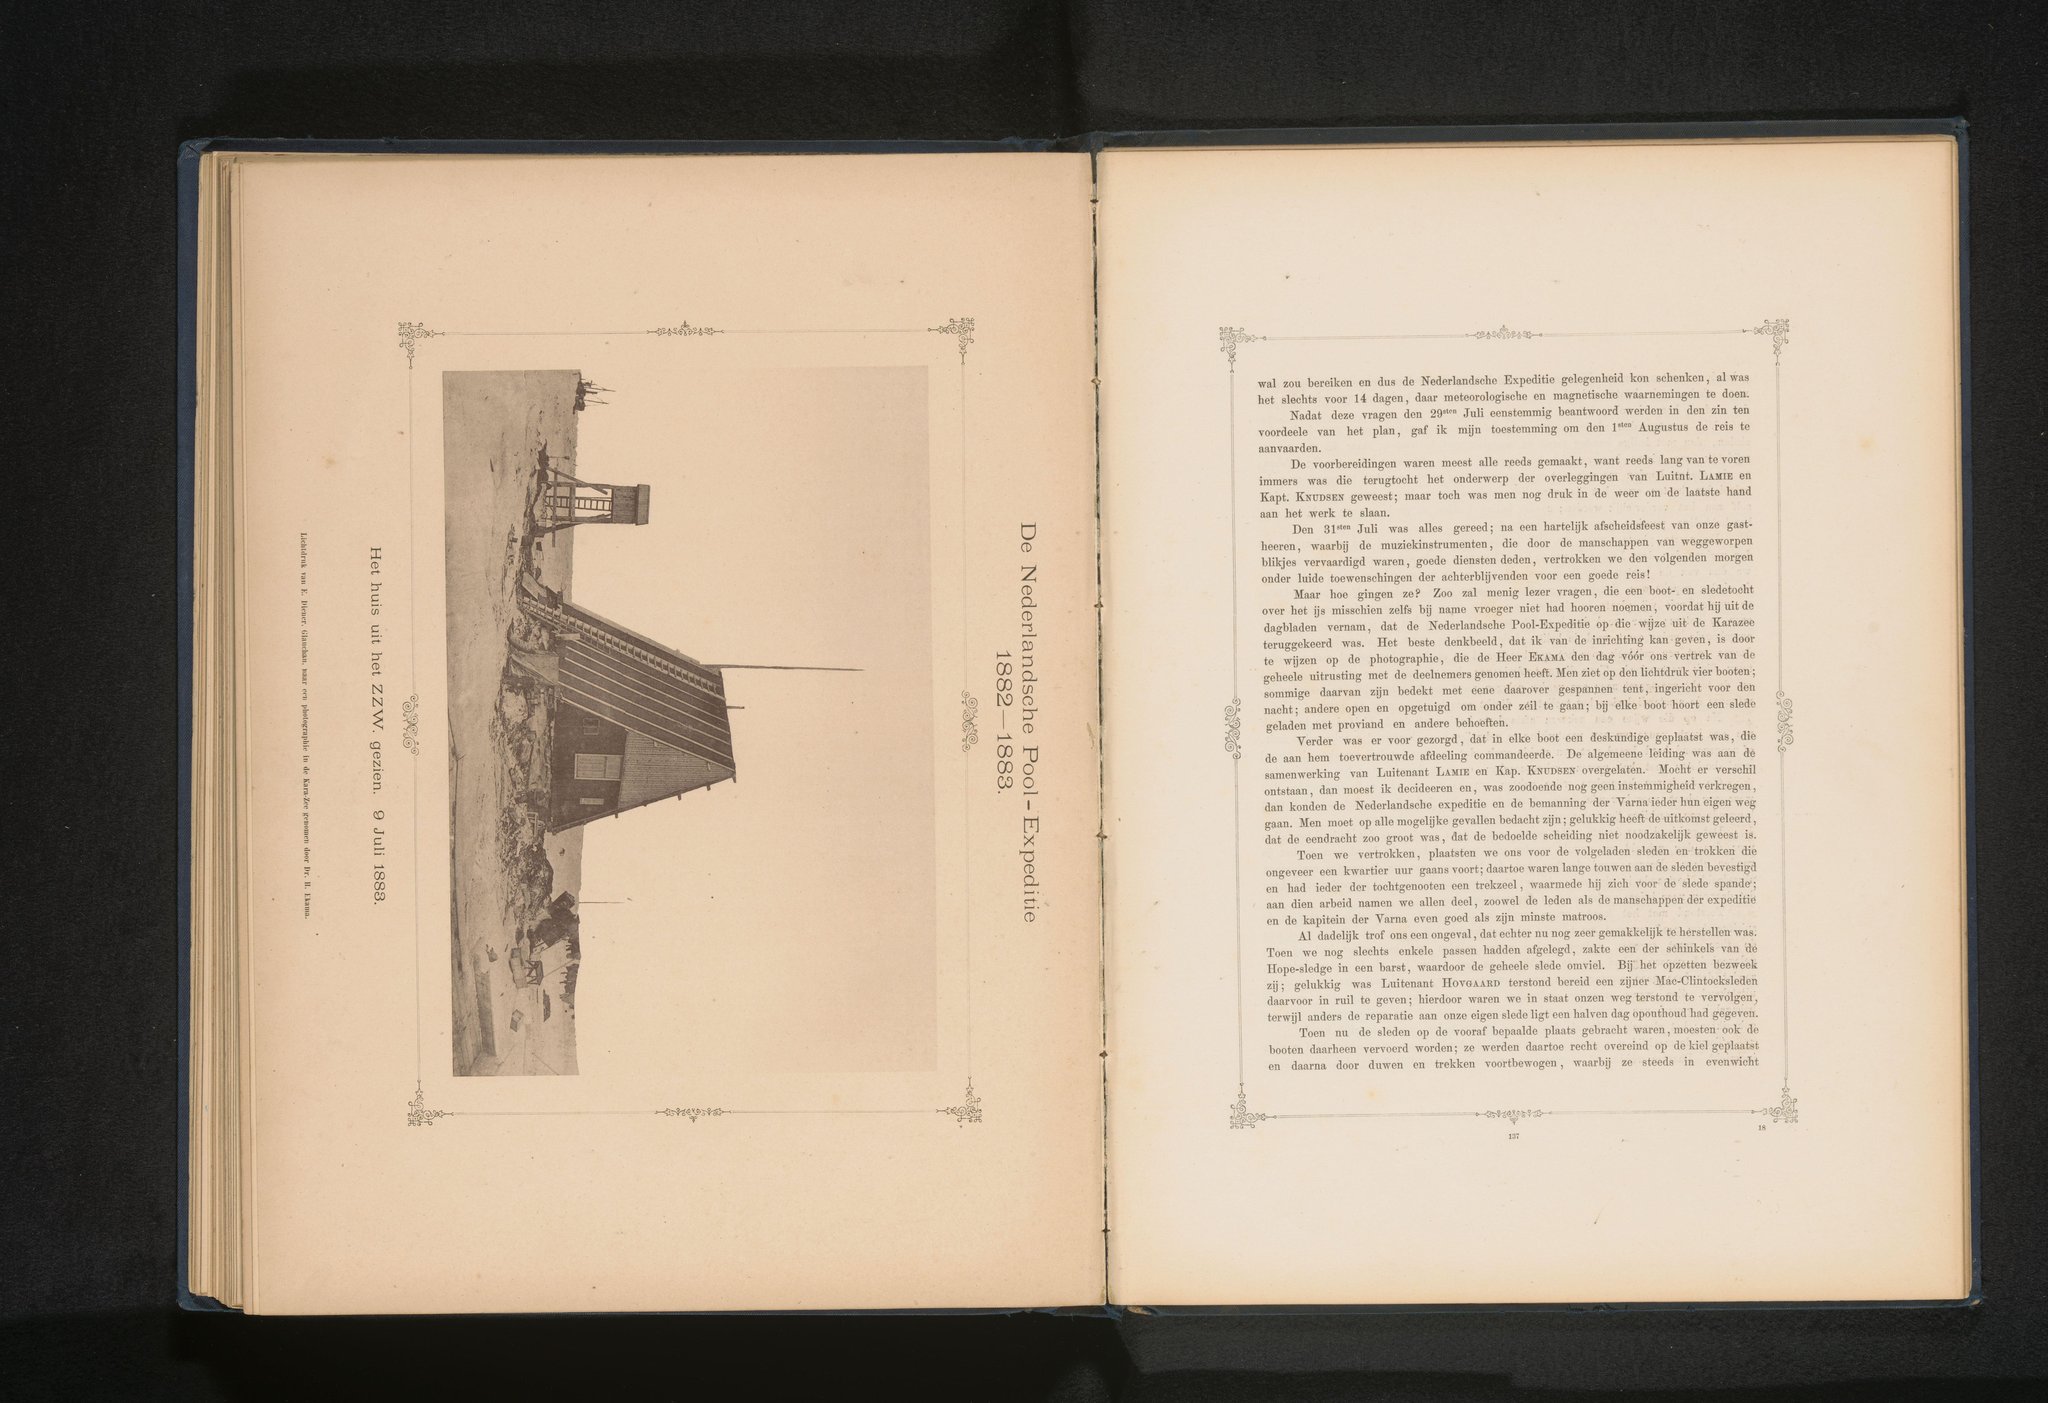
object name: photomechanical print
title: Het huis uit het ZZW. gezien. 9 Juli 1883.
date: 1881-1886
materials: paper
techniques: photograph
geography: kara sea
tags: icefield, landscapes in polar regions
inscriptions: inscription: ‘De Nederlandsche Pool-Expeditie 1882-1883’